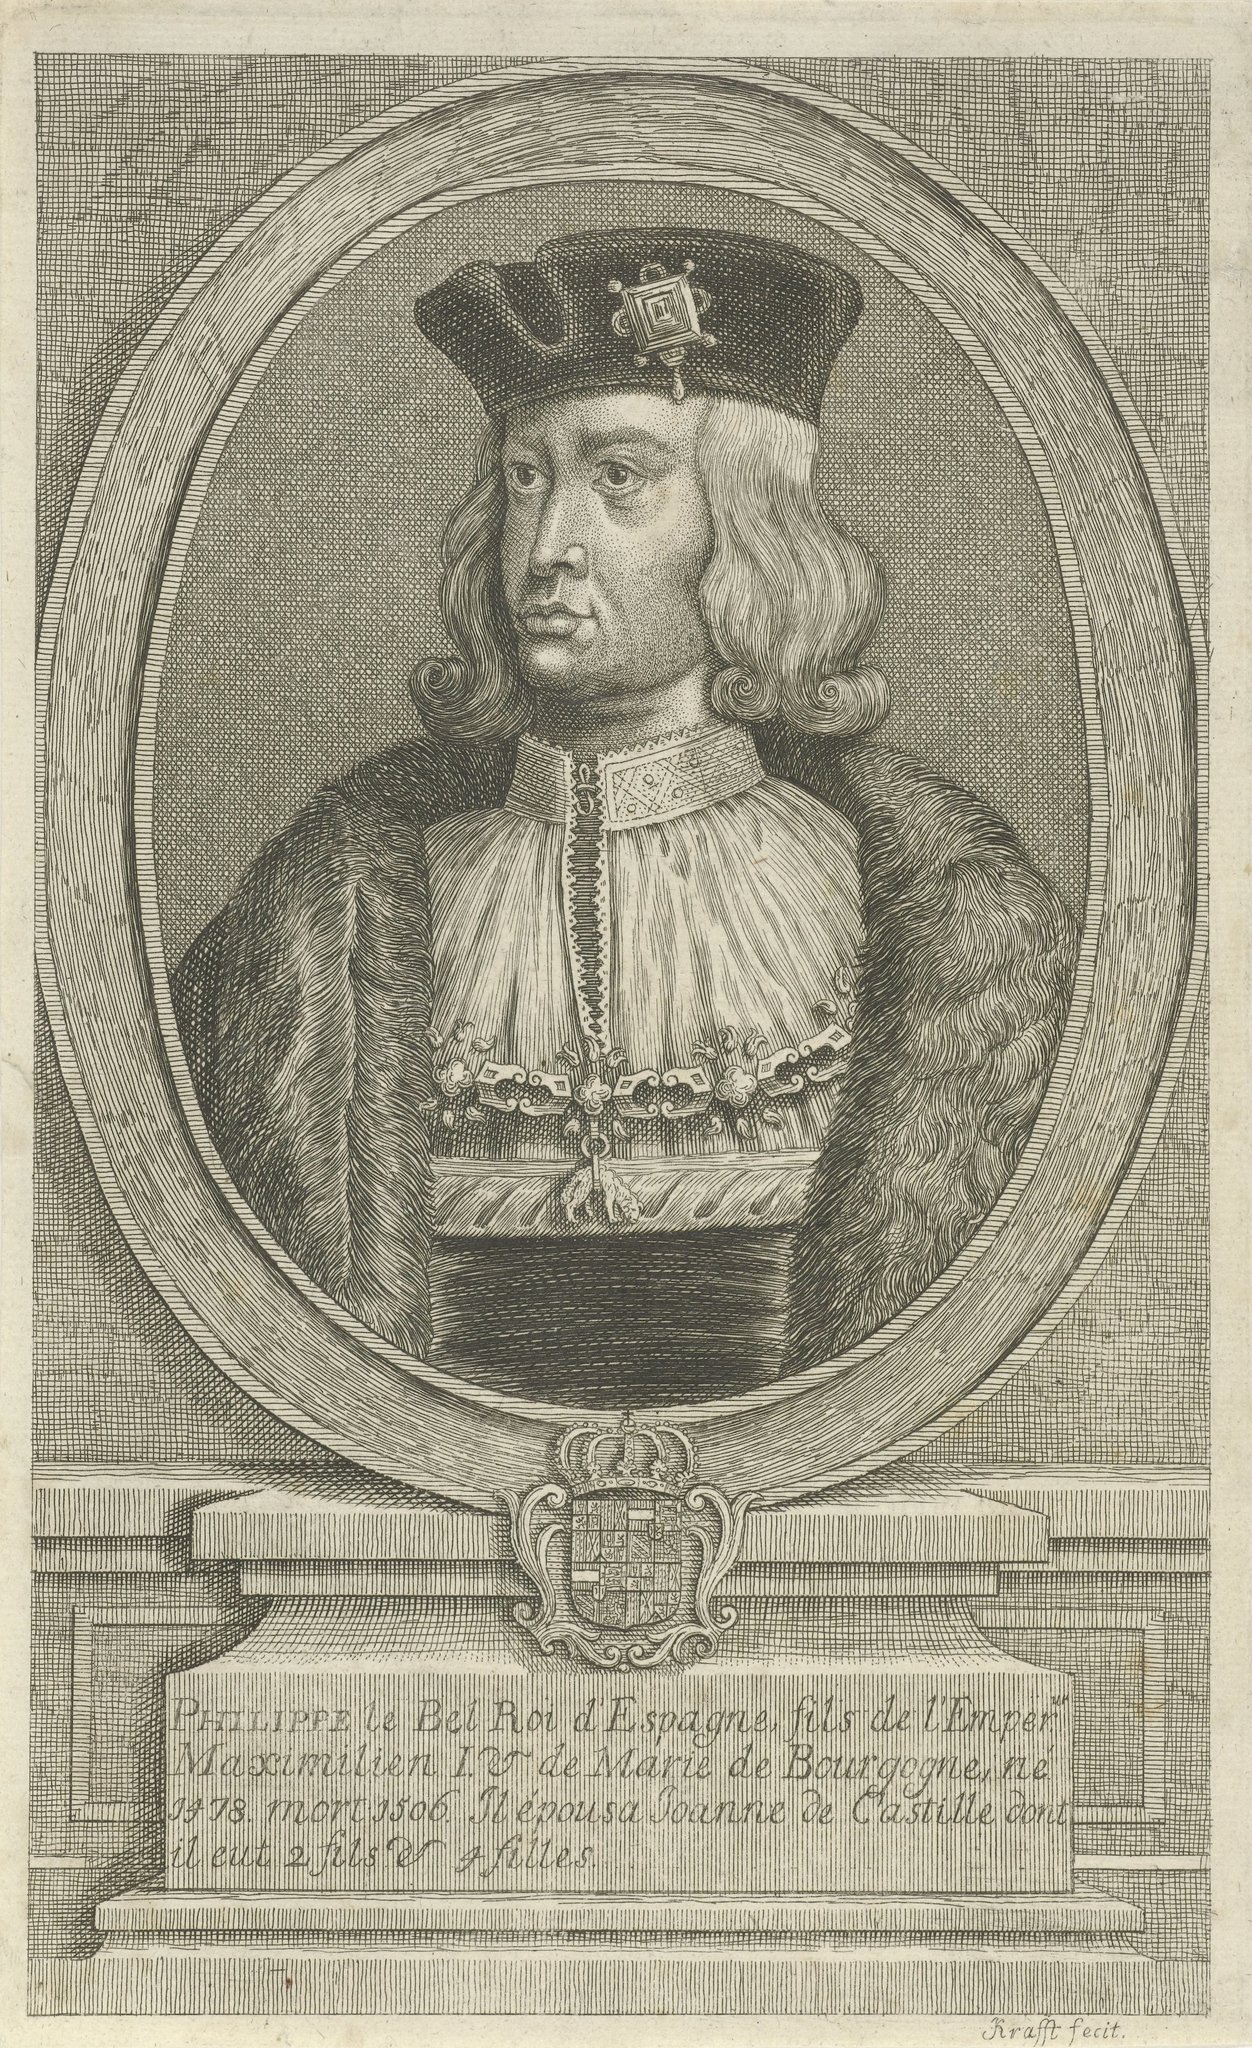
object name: print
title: Portret van Philips de Schone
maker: jan lauwryn krafft (i)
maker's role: print maker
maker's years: 1694-1785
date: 1704-1765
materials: paper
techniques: engraving, etching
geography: southern netherlands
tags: bruges, filips de schone (hertog van bourgondië), historical persons, knighthood order of the golden fleece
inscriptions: collector's mark: Lugt 2228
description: Portretbuste van Philips de Schone (1478-1506), aartshertog van Oostenrijk, hertog van Bourgondië. Om de hals een ketting met het teken van de Orde van het Gulden Vlies. Op een plint zijn naam en titels.